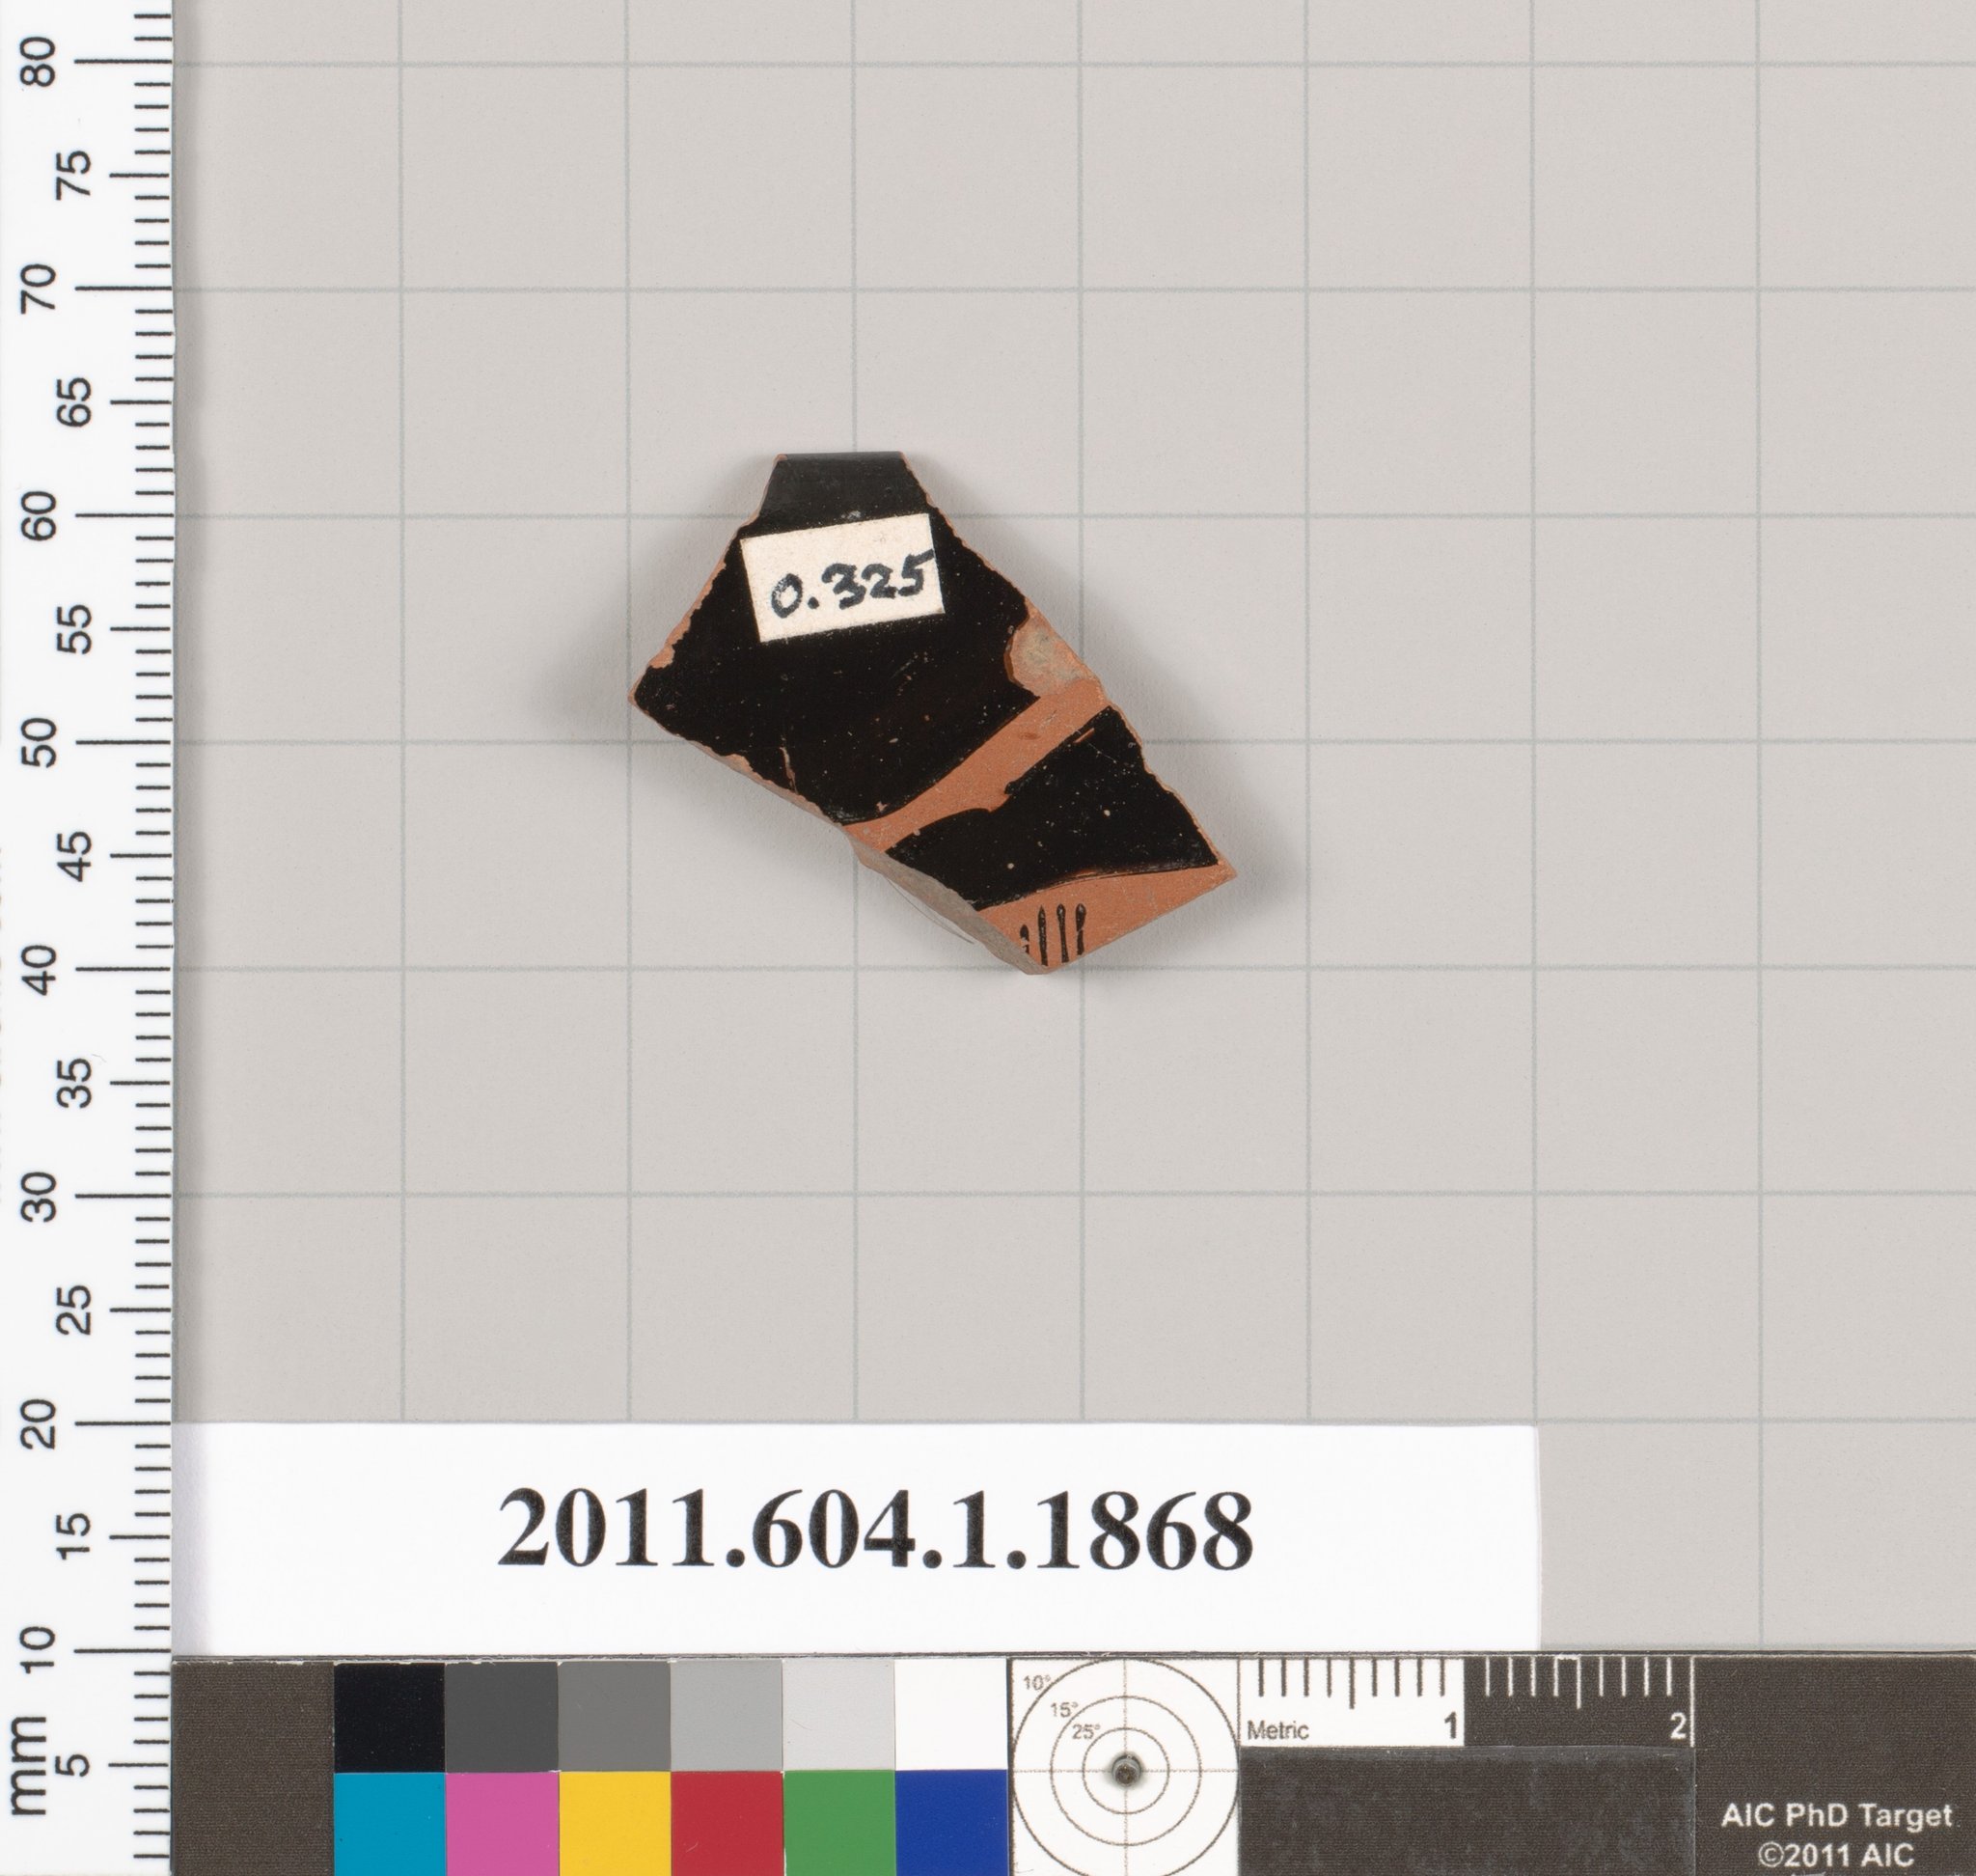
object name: kylix fragment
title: Terracotta rim fragment of a kylix (drinking cup)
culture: greek, attic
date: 475-451 BCE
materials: terracotta